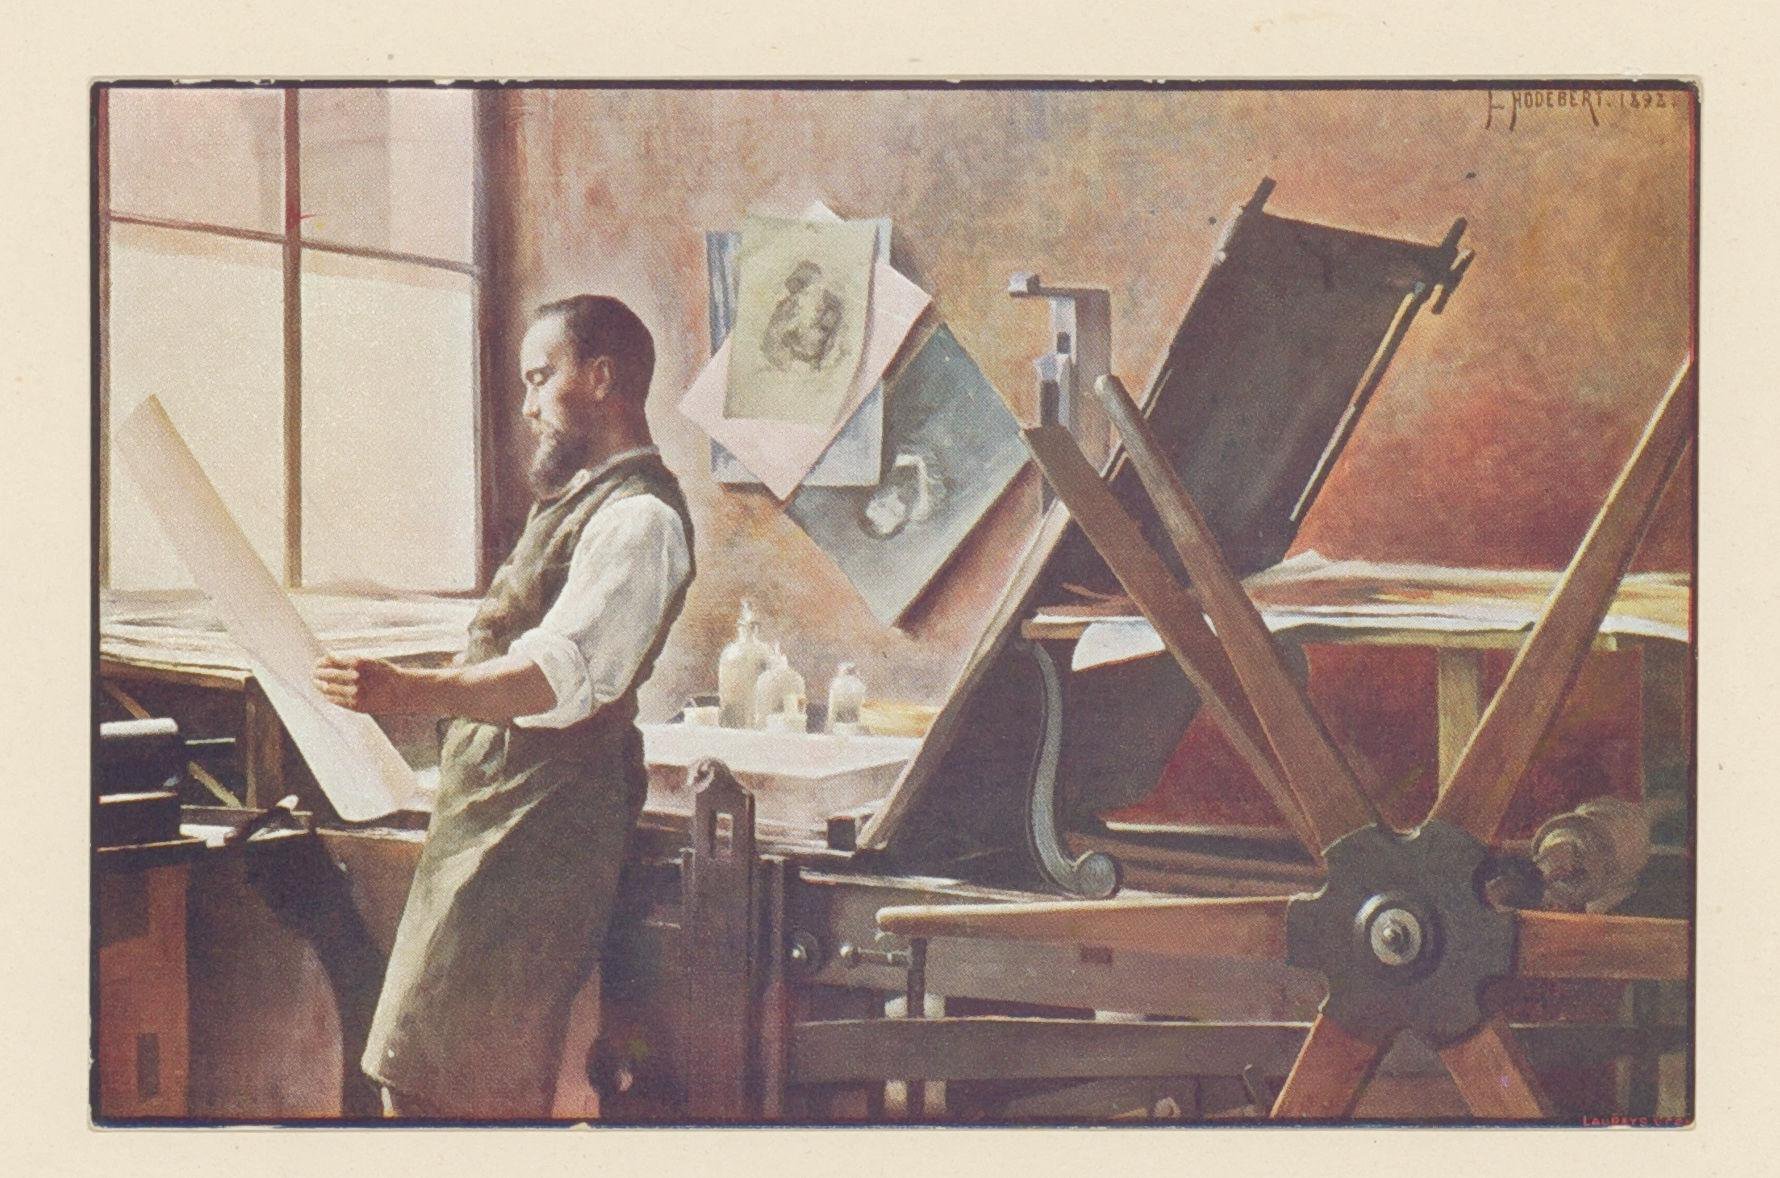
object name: photomechanical print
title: Prentmaker in zijn atelier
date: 1914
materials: paper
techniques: letterpress printing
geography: paris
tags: print, e.g.: engraving, etching, lithograph, portrait, self-portrait of graphic artist, paris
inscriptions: collector's mark: Lugt 1641, stamp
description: Prentmaker in zijn atelier. Uitgeven als souvenir van de grafische kunst tentoonstelling in 1914. Onderwerpsrubrieken binnen de Atlas Zeden en Gewoonten: Handel, nijverheid en verkeer, Koophandel, Veilingen, Makelaardij en Verzekeringswezen, Oude adreskaarten van winkels en fabrieken, reclame.